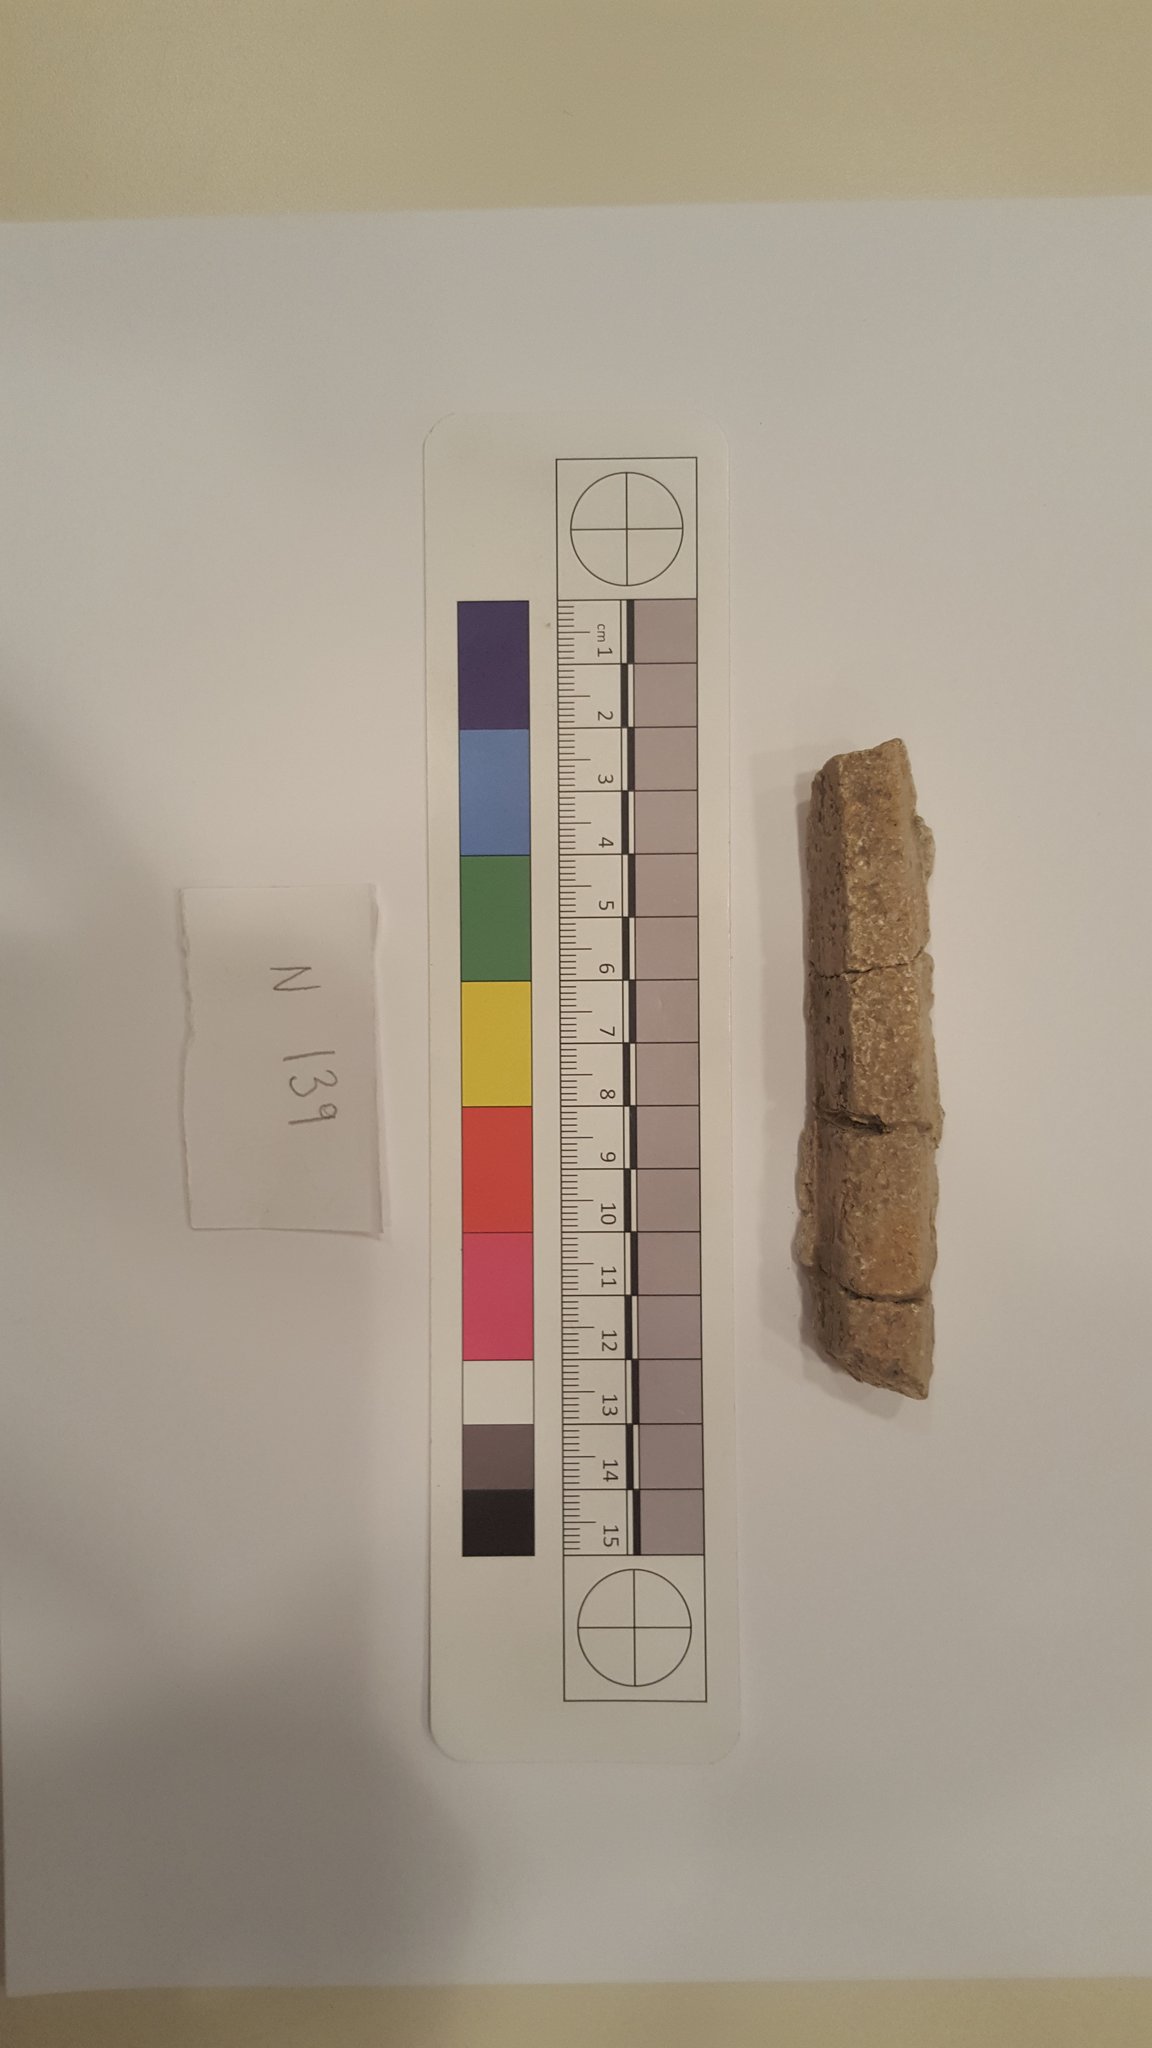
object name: fragment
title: Stucco Fragment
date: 701-1200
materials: plaster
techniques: carving, painting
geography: iran